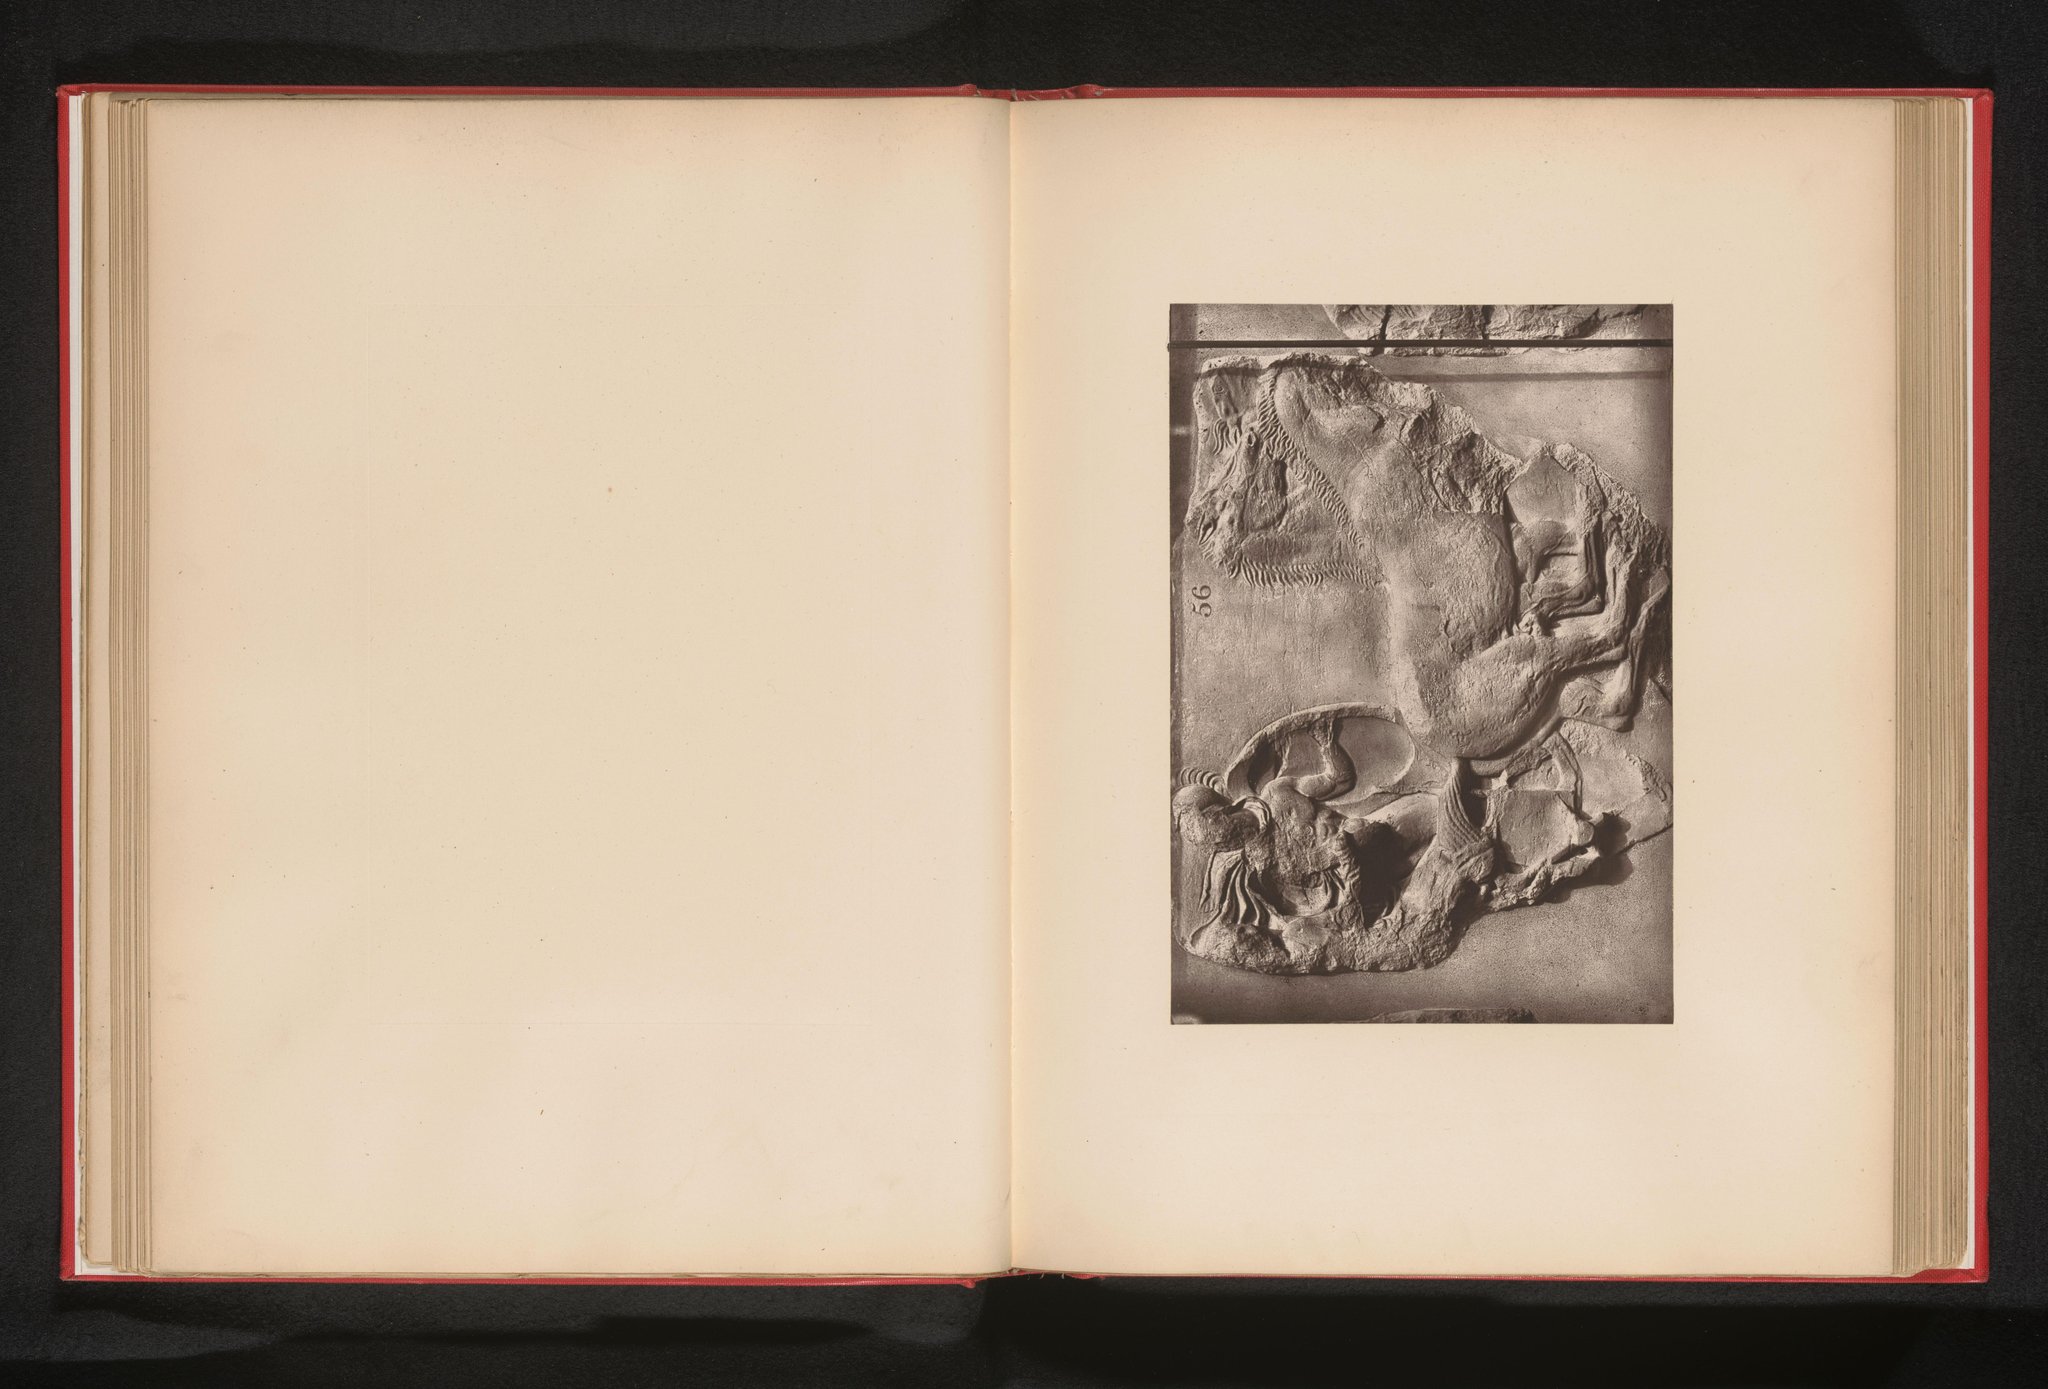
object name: photomechanical print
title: Fries van het Parthenon met strijdwagen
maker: stephen thompson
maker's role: fotograaf, schrijver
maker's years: 1831-1893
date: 1873-1878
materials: paper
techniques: woodburytype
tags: victor (after the battle), sculpture (+ relief ~ sculpture)